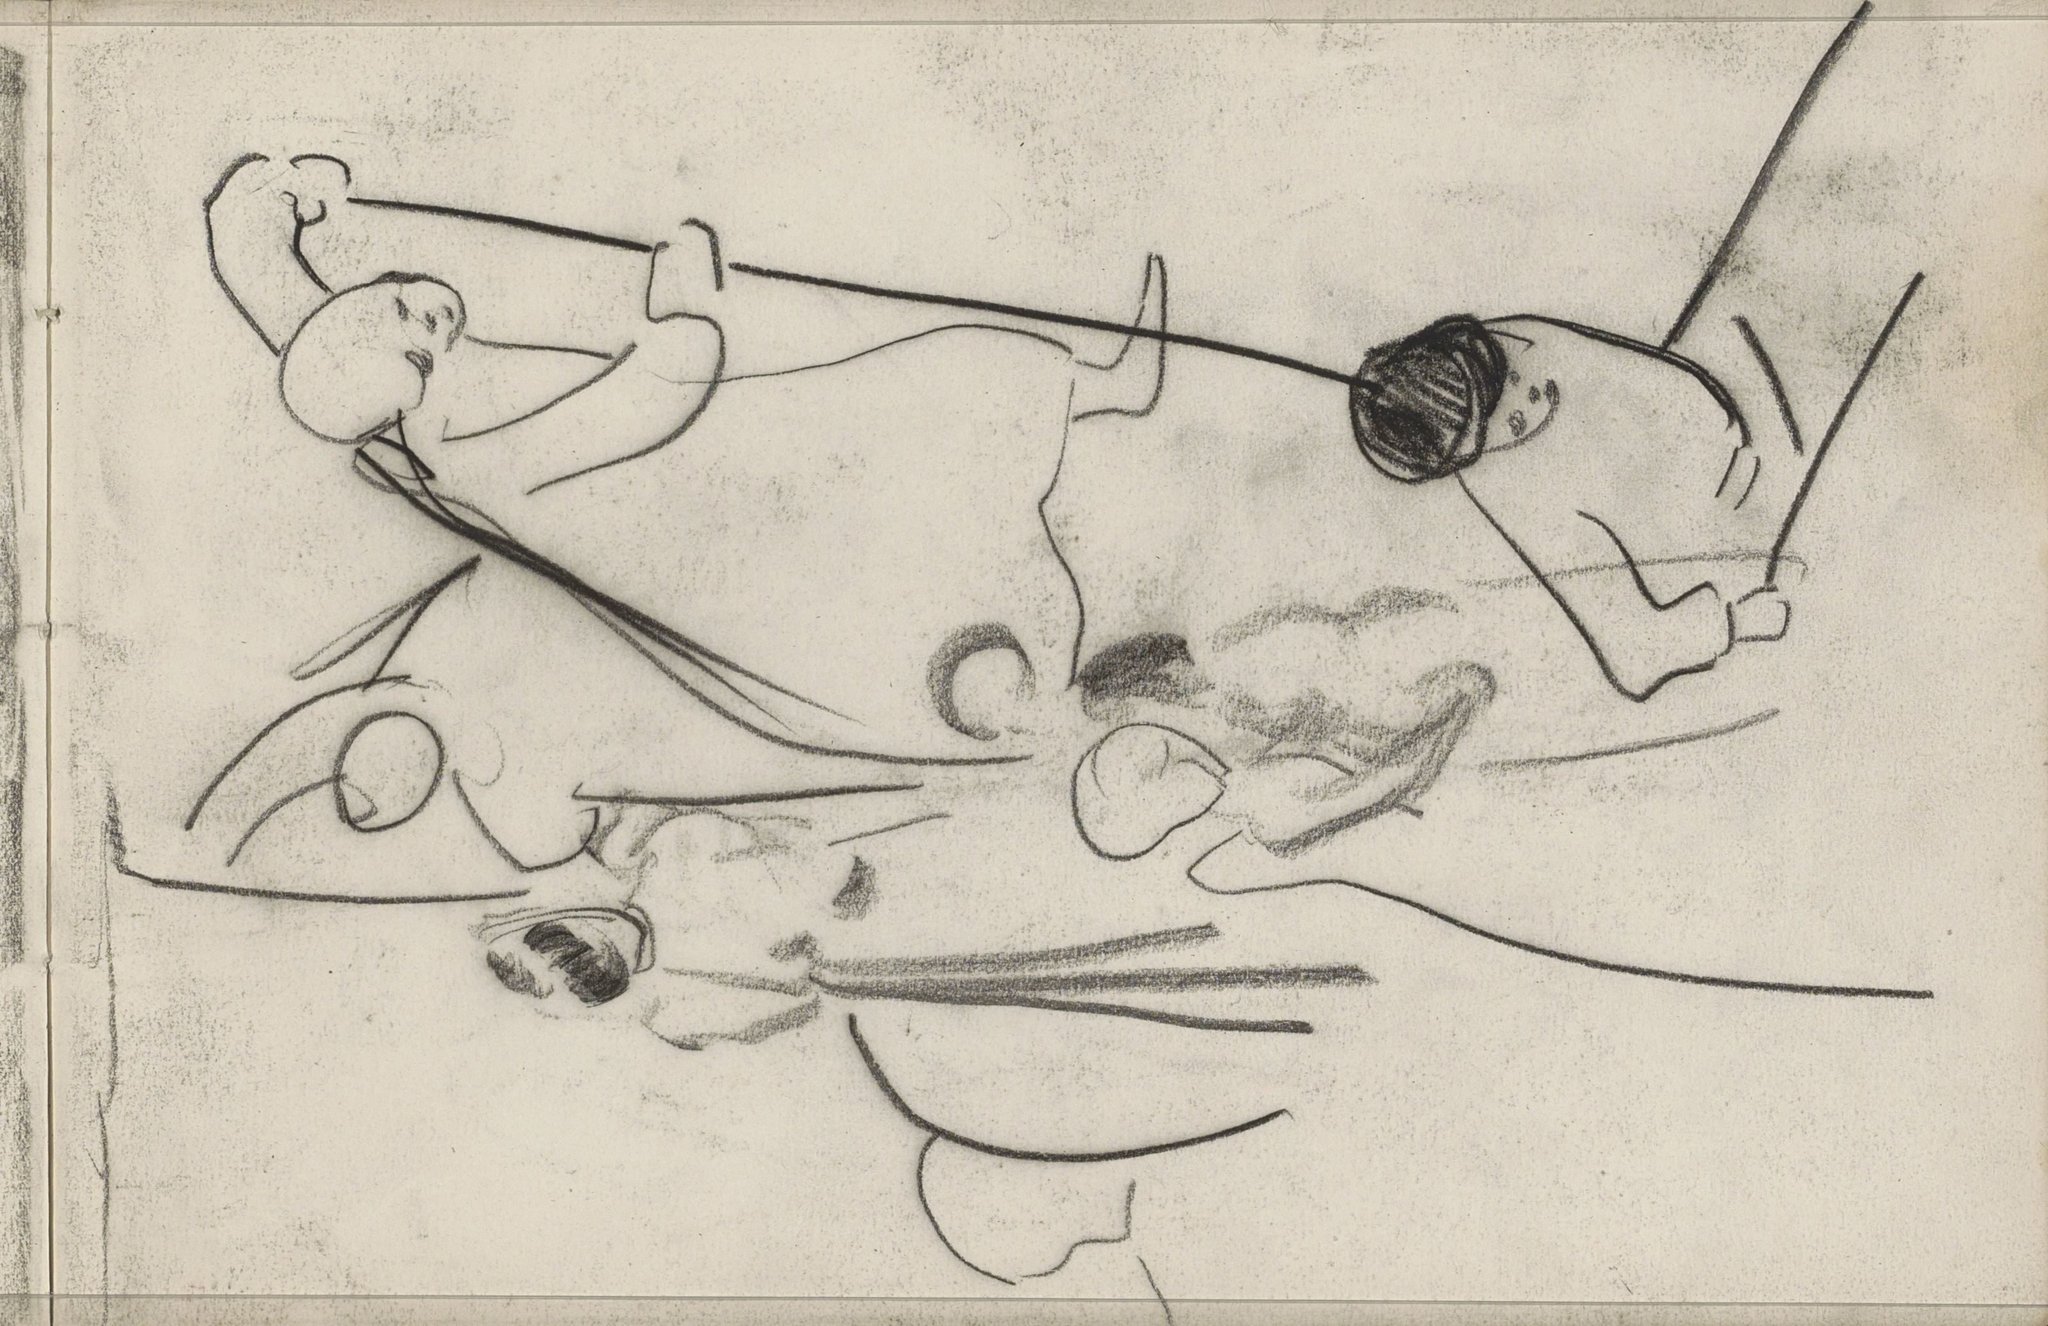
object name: sketchbook leaf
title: Figuren met stokken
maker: carel adolph lion cachet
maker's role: draughtsman, print maker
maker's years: 1864-1945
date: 1895-1900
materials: chalk, paper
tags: anatomy (non-medical)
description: Tevens een figuur met een kruiwagen of ladder. Blad 13 recto uit een schetsboek met 19 bladen.